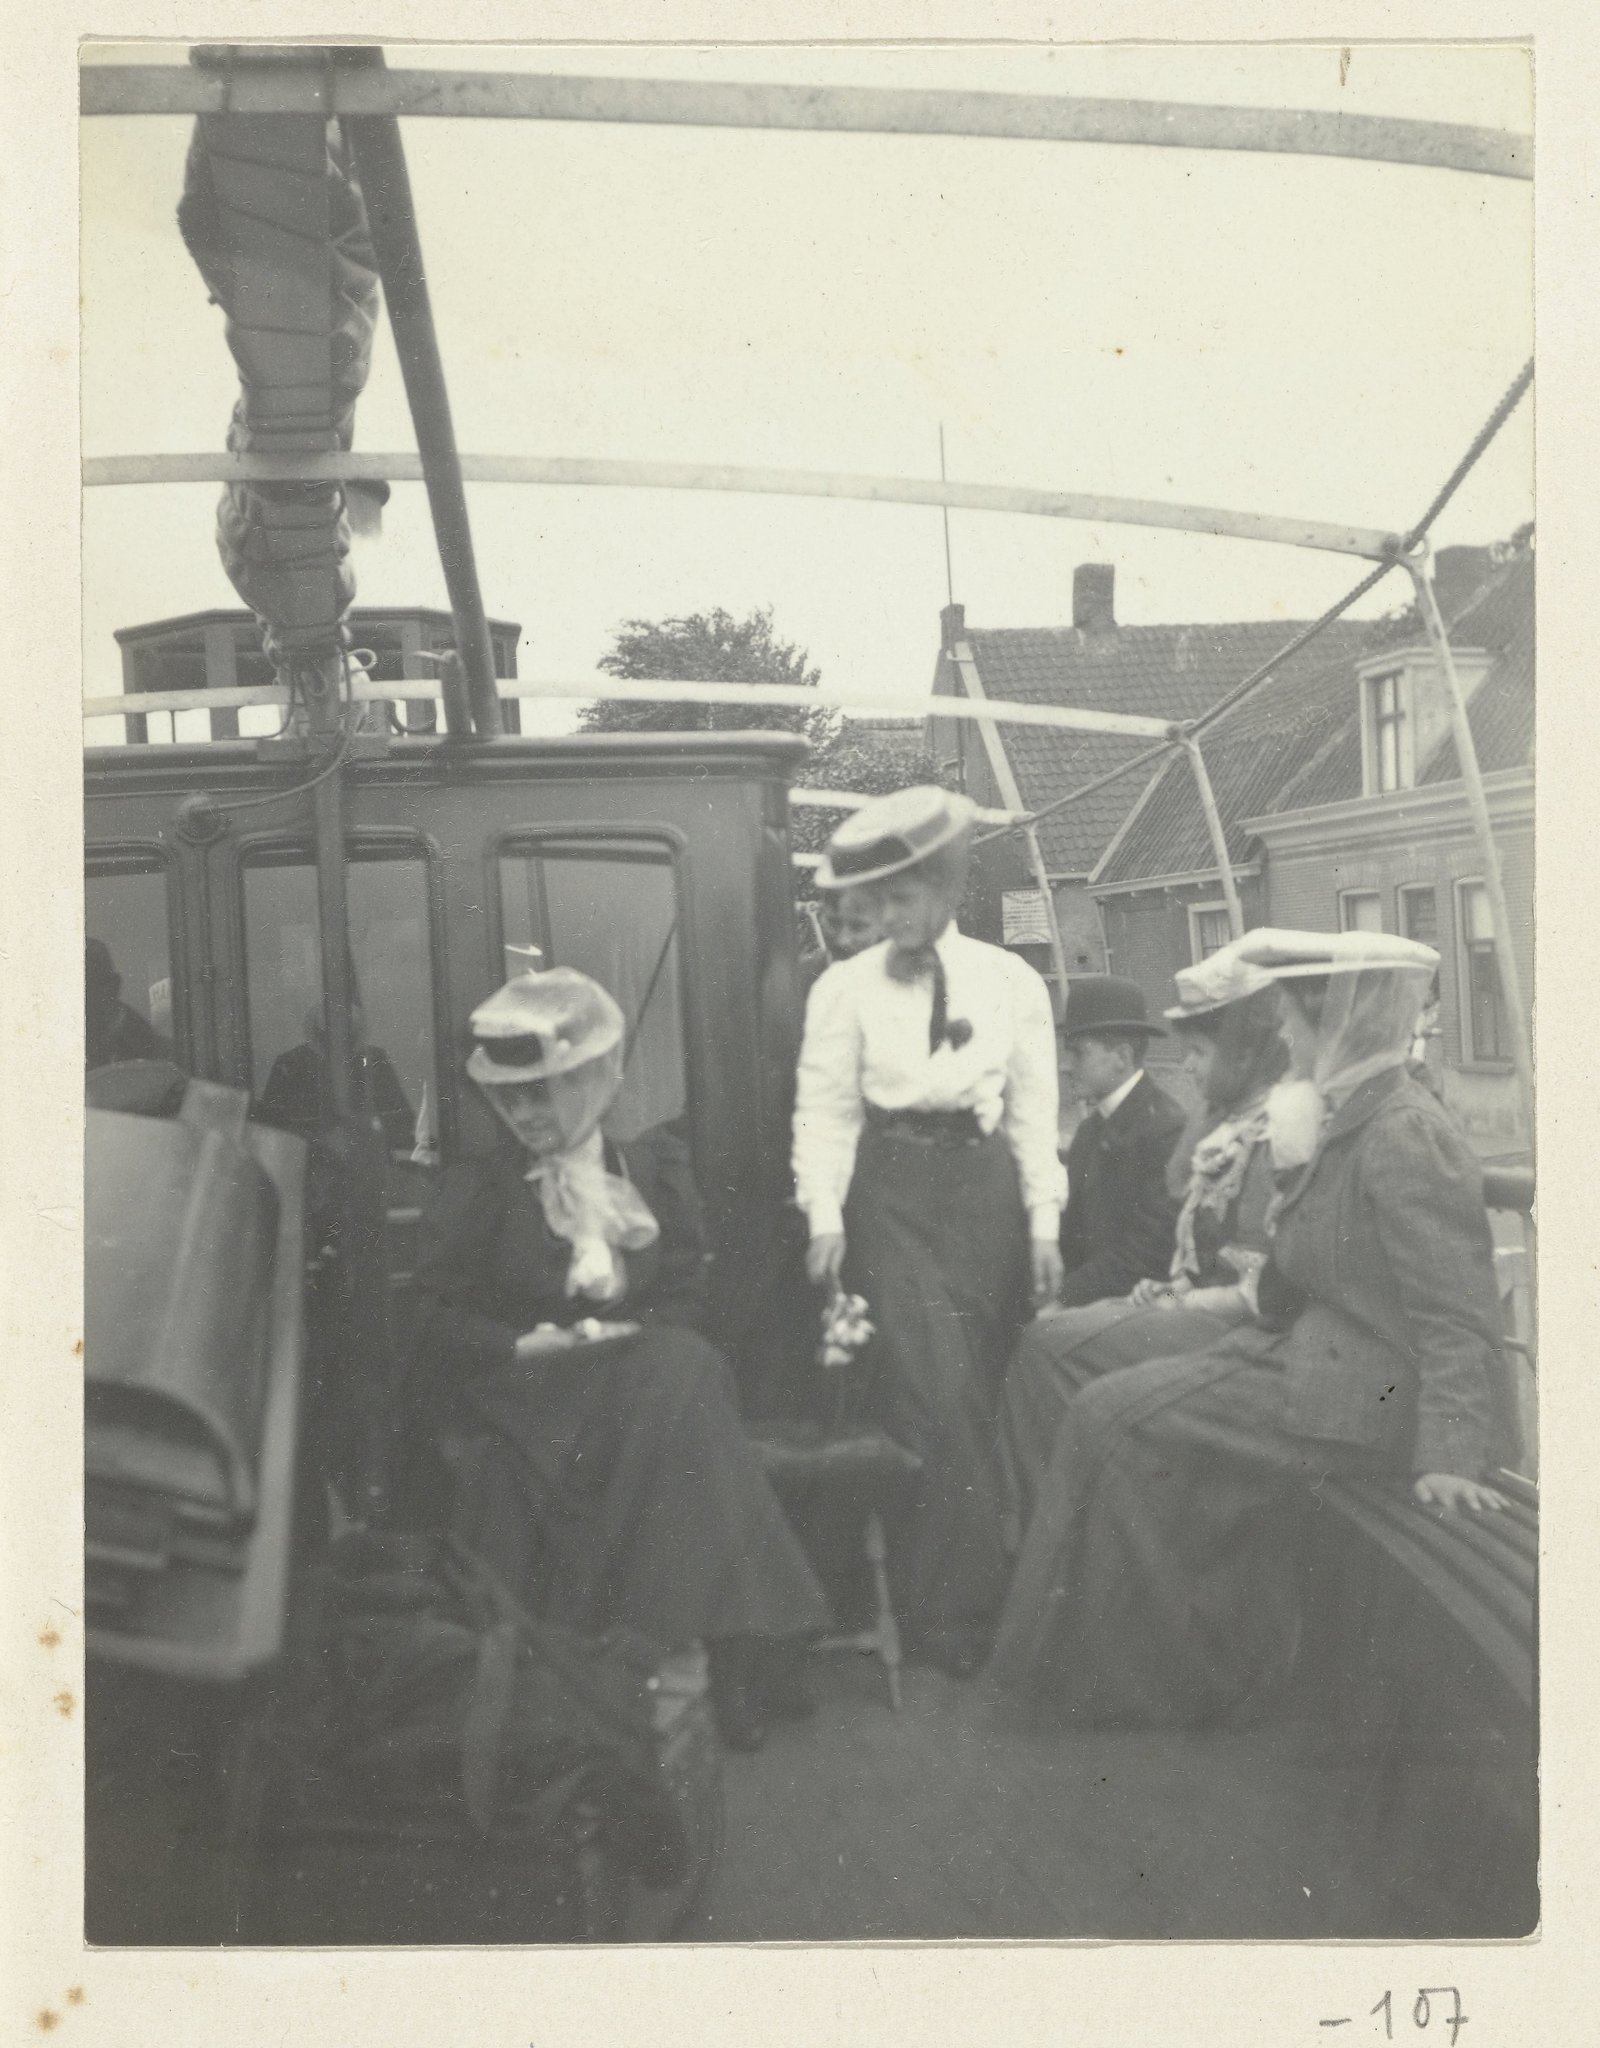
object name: photograph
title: Aan boord van een boot bij een bruiloft of feest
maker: geldolph adriaan kessler (dolph)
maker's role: fotograaf, industrieel, voetballer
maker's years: 1884-1945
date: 1903-1908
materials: cardboard, photographic support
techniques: gelatin silver print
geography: netherlands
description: Aan boord van een boot bij een bruiloft of feest. Onderdeel van het fotoalbum van Dolph Kessler met opnamen die hij maakte tijdens zijn verblijf in Engeland en op een wereldreis die hij als secretaris van Henri Deterding (directeur Koninklijke Olie) ondernam naar Nederlands-Indië, Japan, China en de Verenigde Staten, tussen 1906 en 1908.